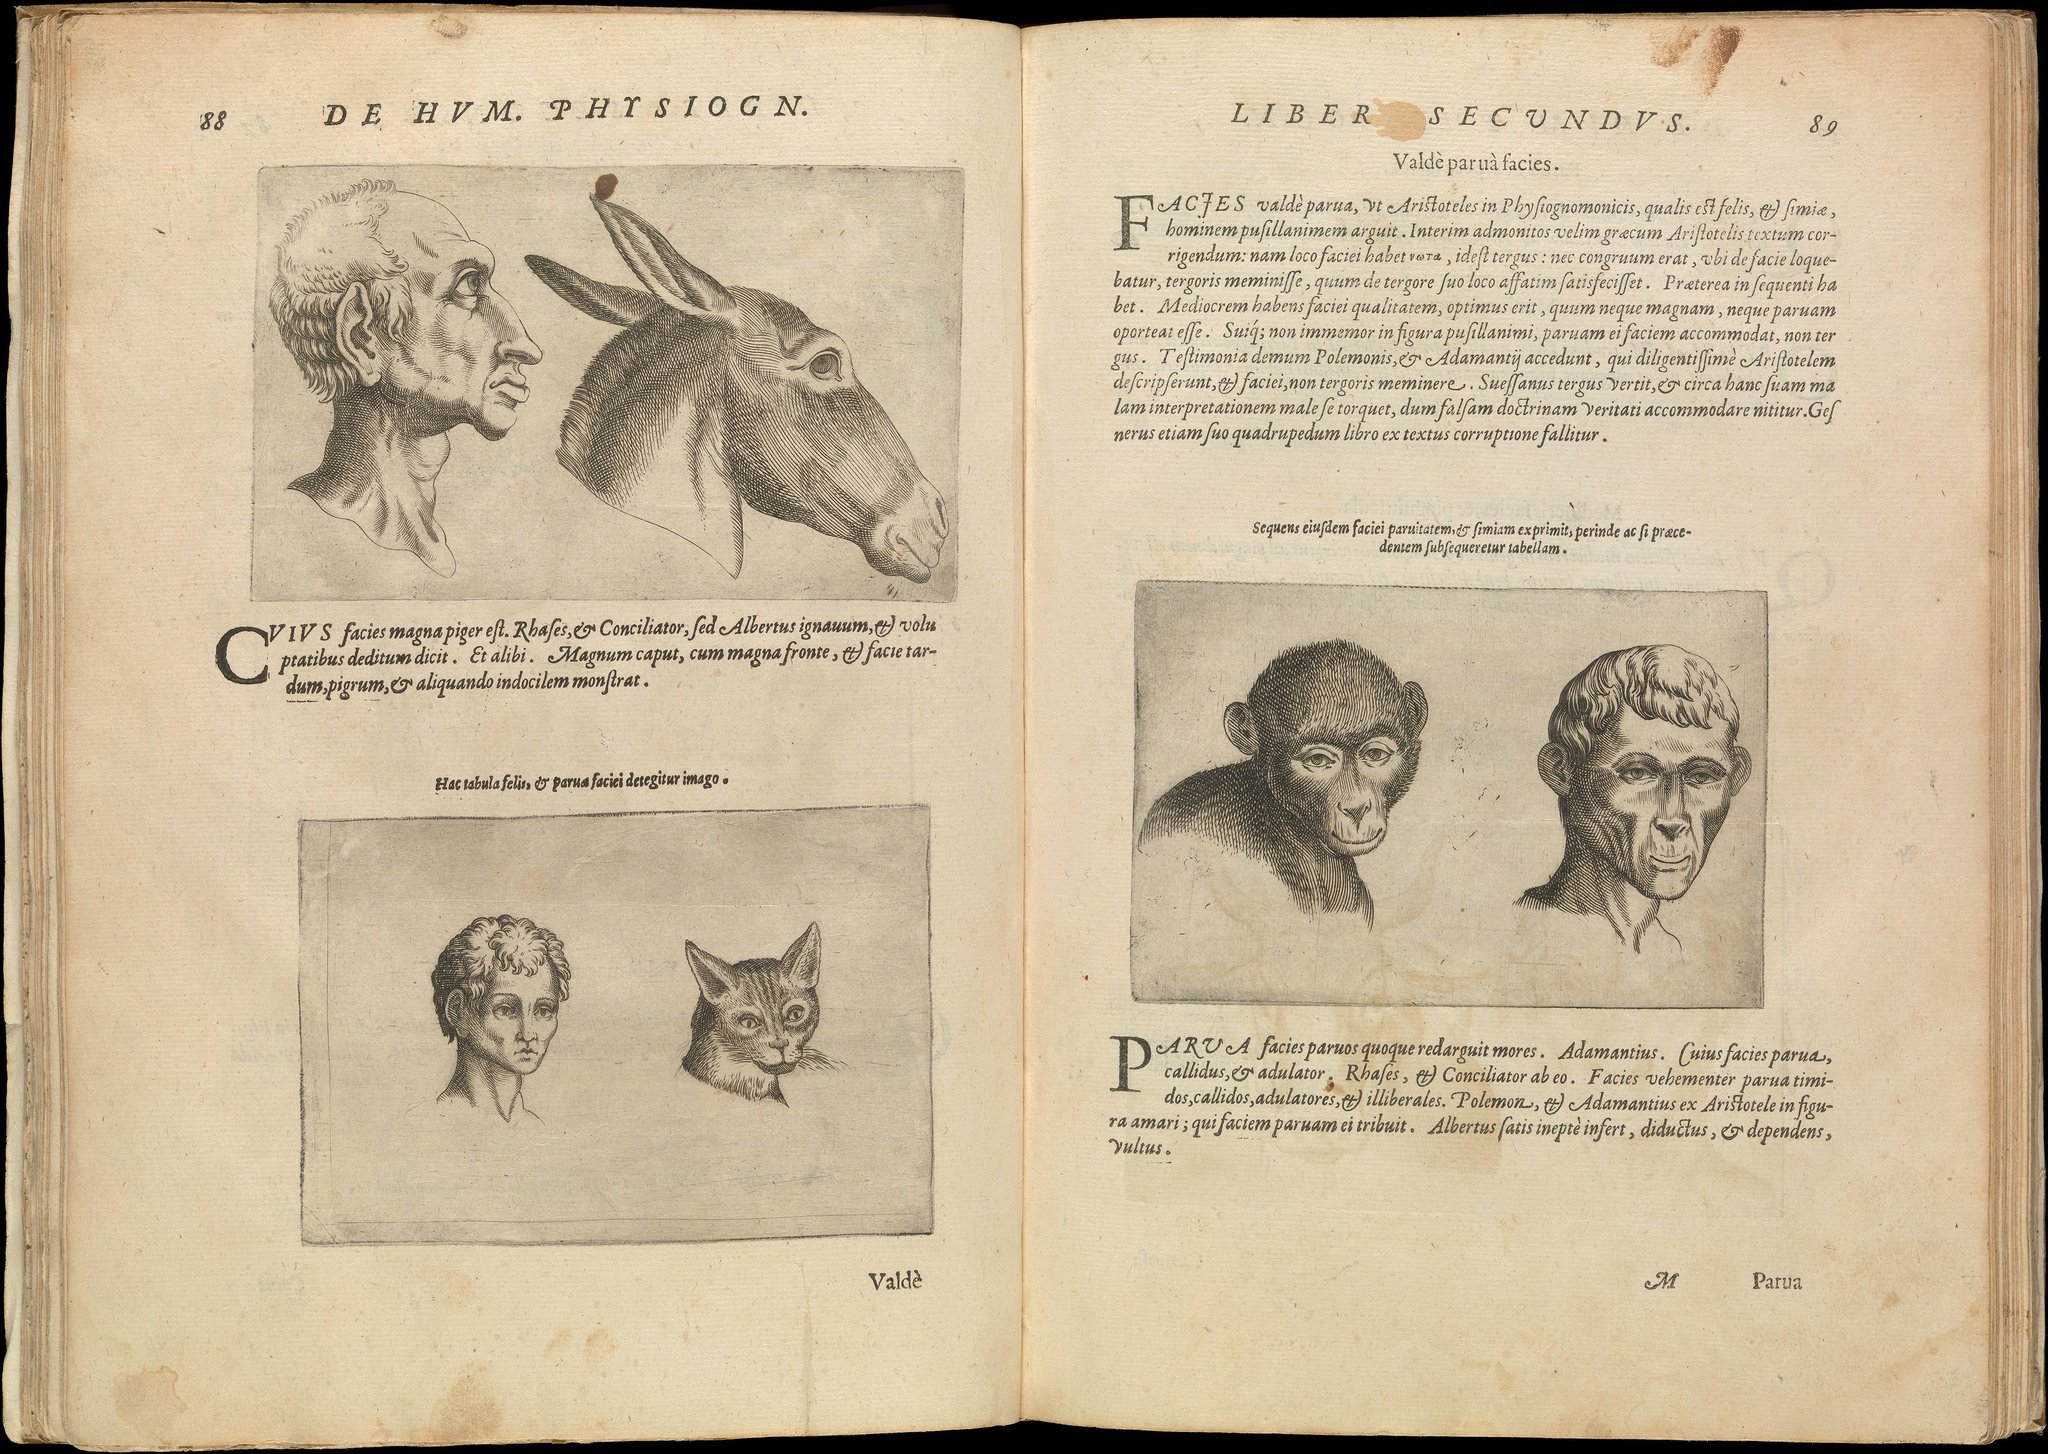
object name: book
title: De Humana Physiognomonia. Libri III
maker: giovanni battista della porta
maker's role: author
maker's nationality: italian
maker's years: 1538-1615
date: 1586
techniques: engraving, letterpress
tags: men,cats,horses,monkeys